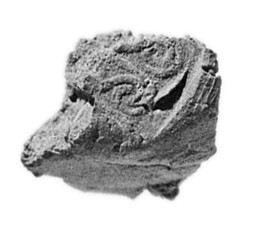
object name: sealing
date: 1981-1640 BCE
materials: mud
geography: egypt